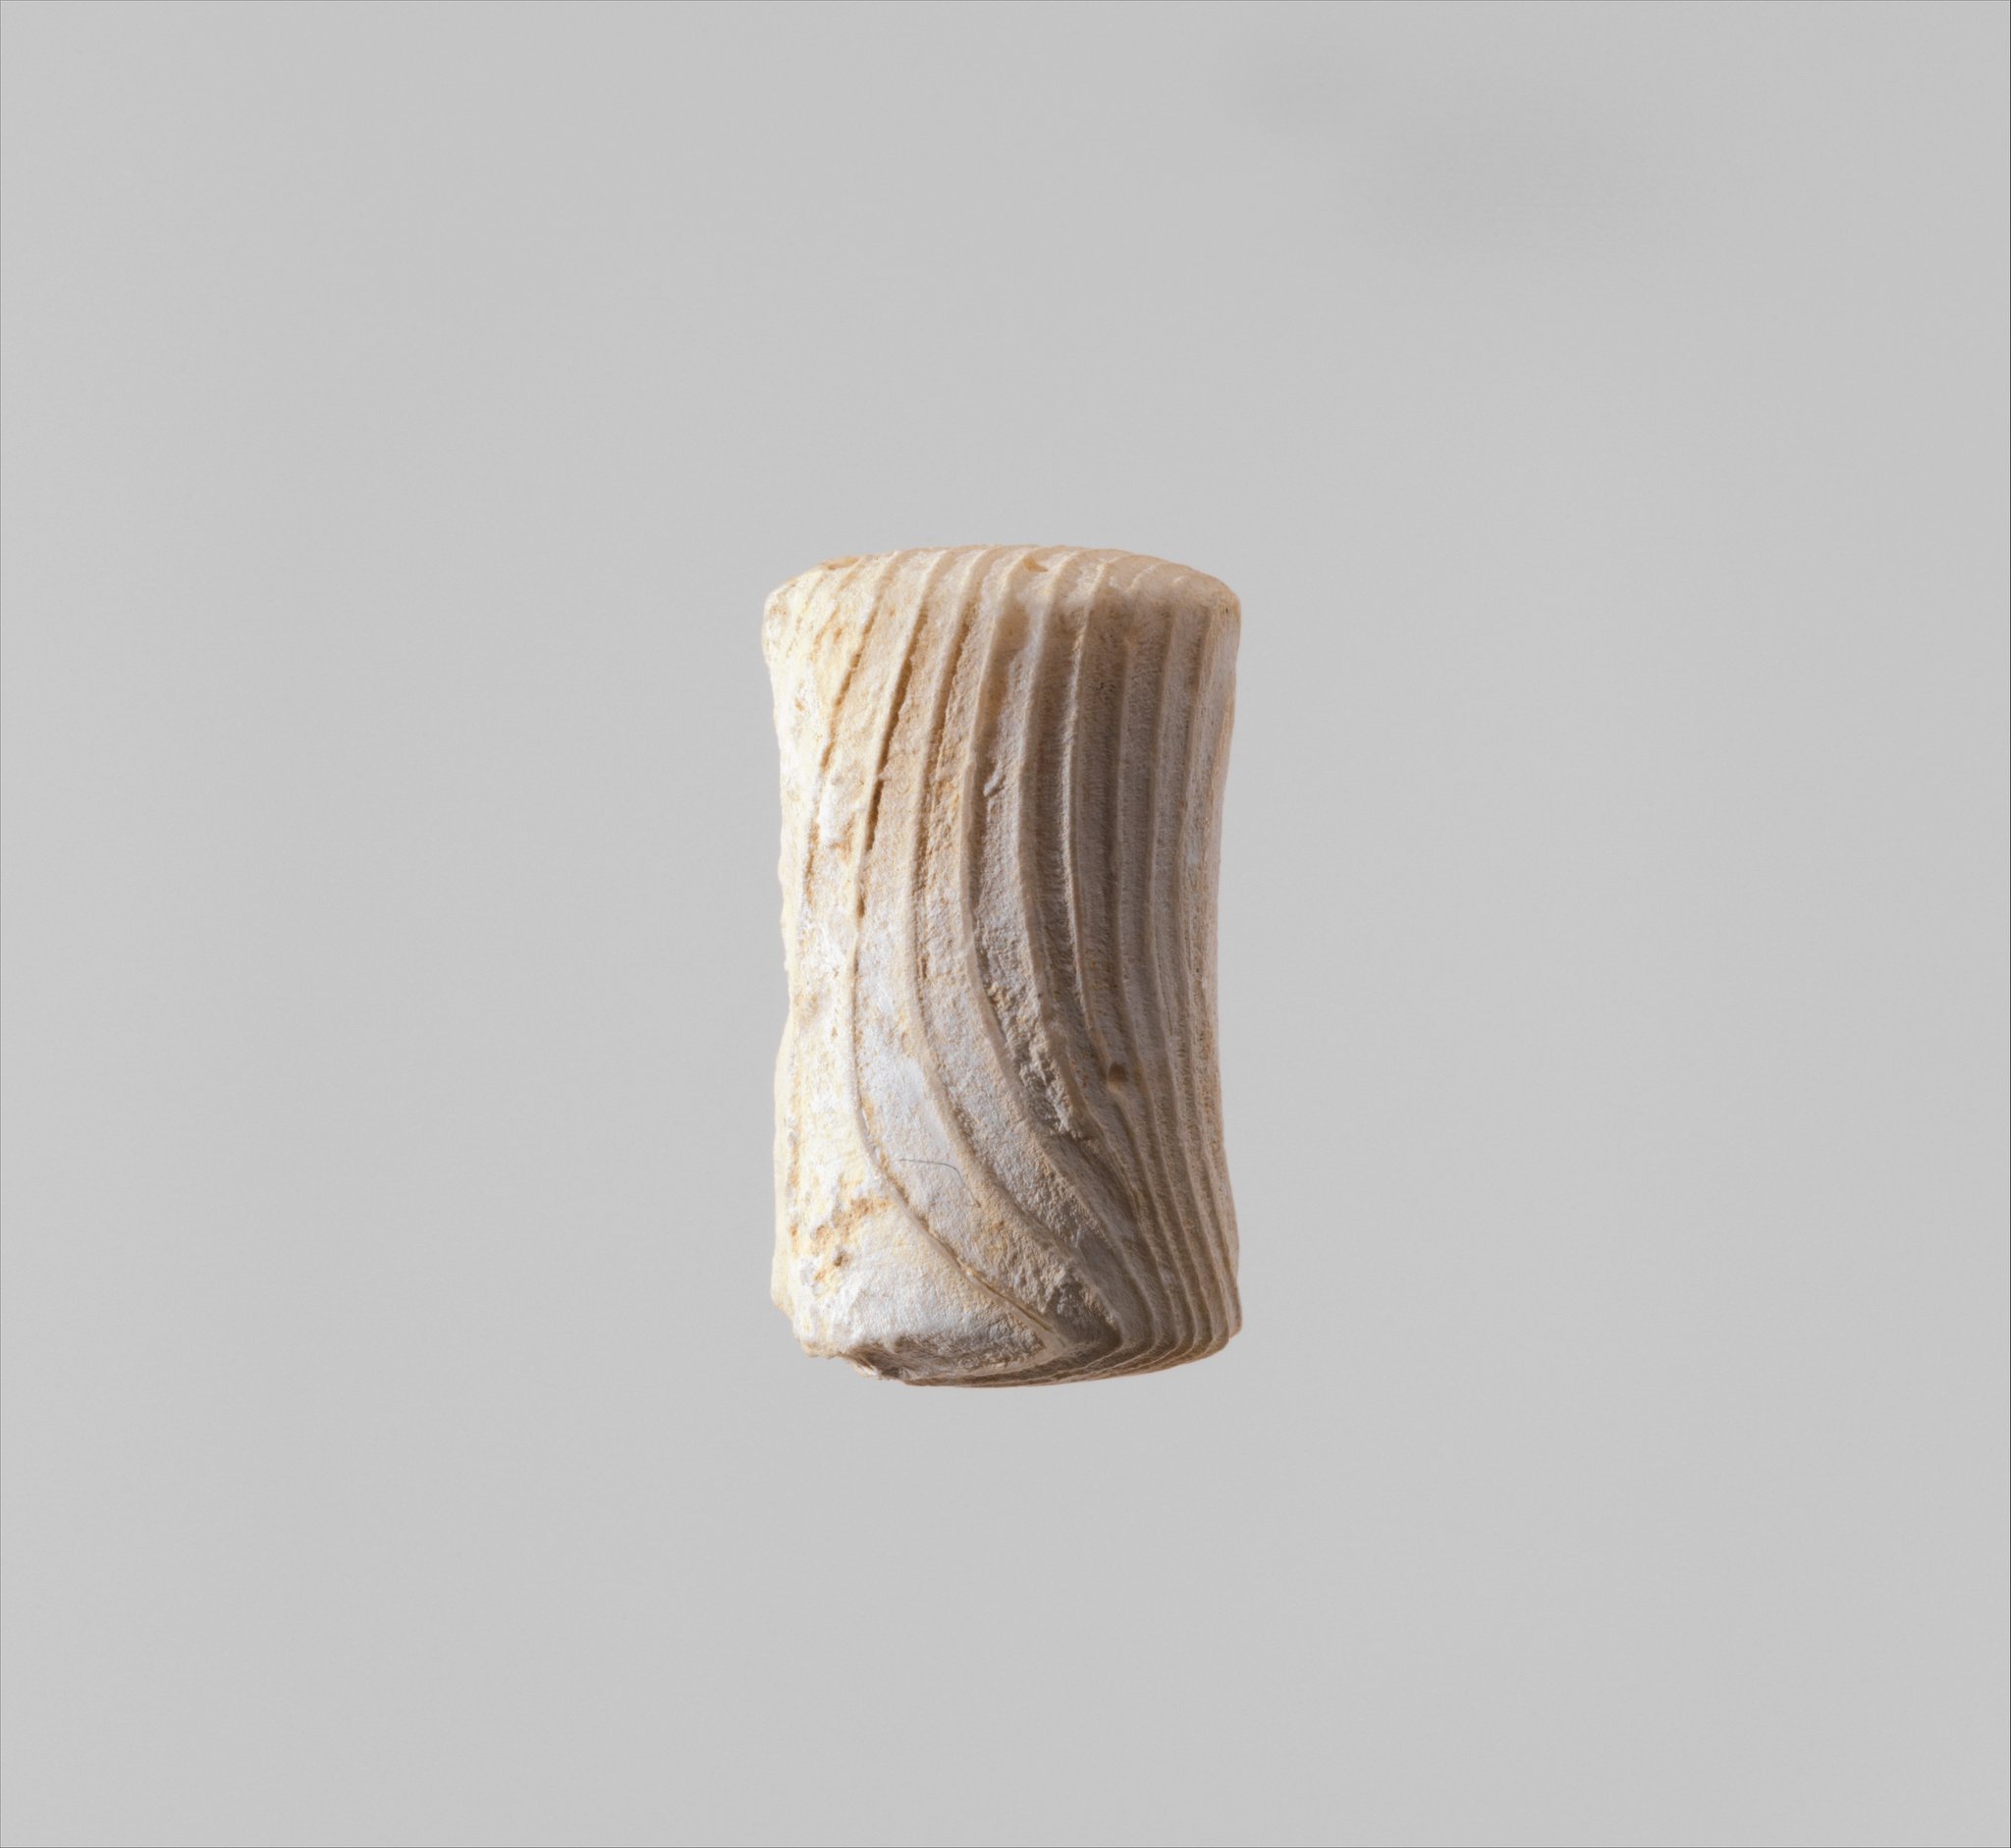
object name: pestle polisher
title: Shell pestle/polisher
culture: cycladic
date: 2700-2400 BCE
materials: shell